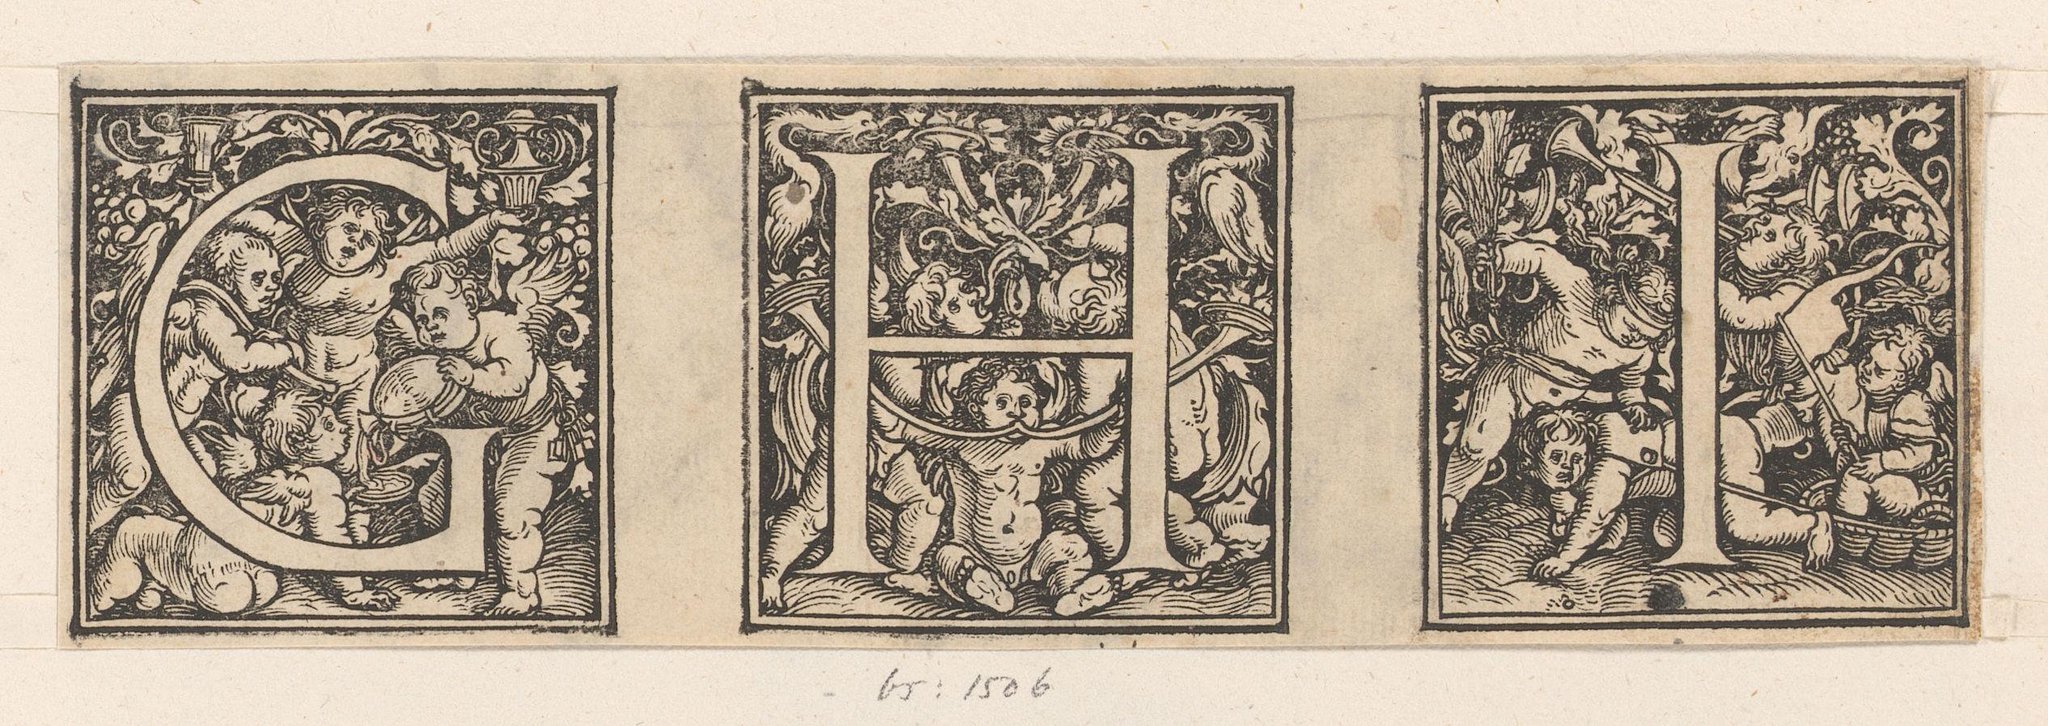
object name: print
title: Latijns alfabet met putti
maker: jost de negker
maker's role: print maker, printer, publisher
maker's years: 1485-1544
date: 1521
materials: paper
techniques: woodcut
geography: augsburg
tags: initial, cupids: 'amores', 'amoretti', 'putti'